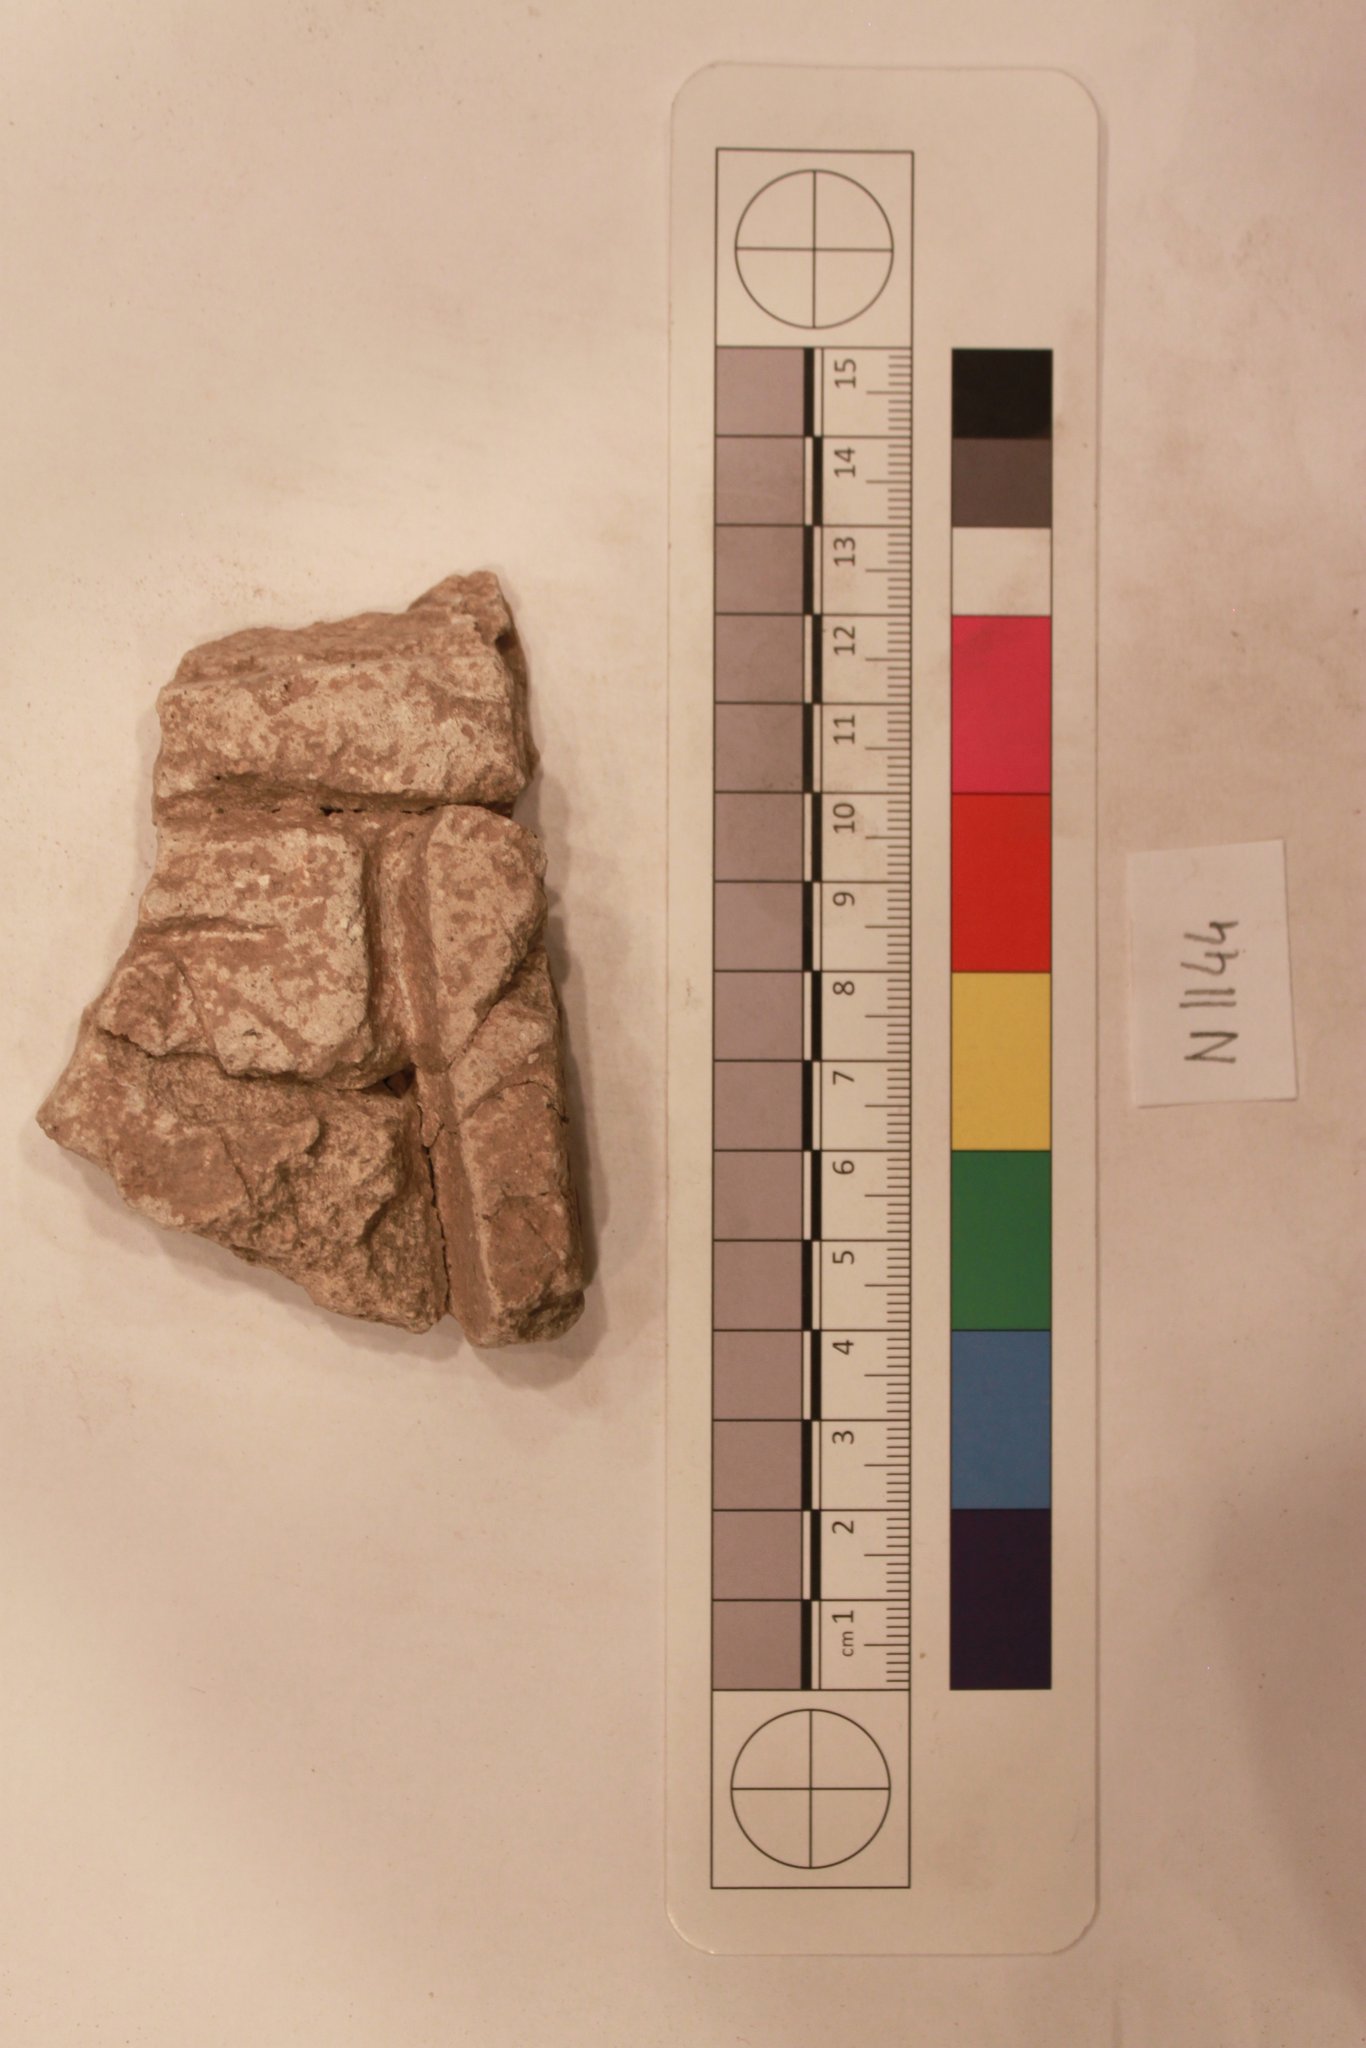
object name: fragment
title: Stucco Fragment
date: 701-1200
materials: plaster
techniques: carving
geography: iran